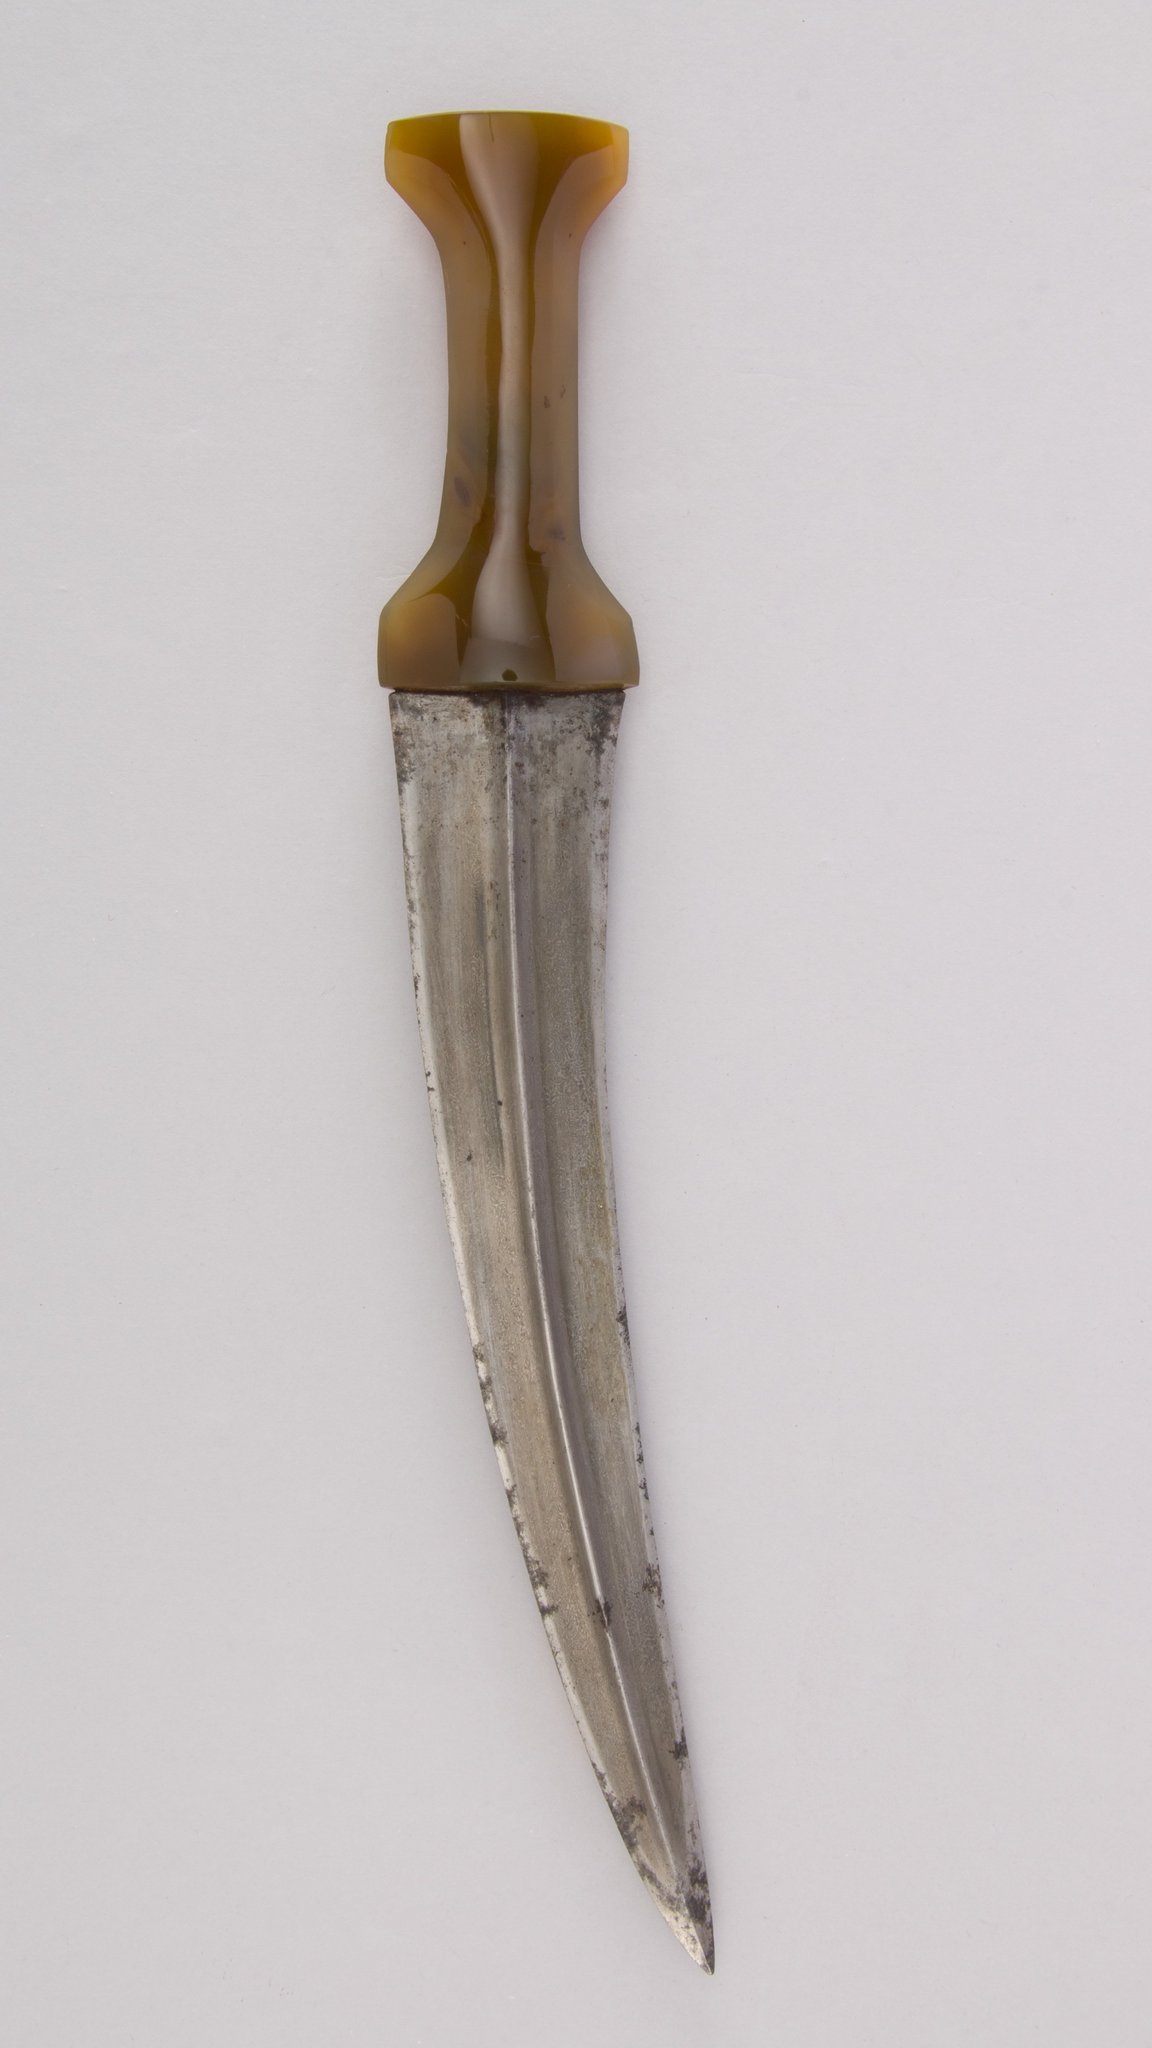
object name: dagger jambiya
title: Dagger (Jambiya)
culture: indian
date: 1801-1900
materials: quartz, steel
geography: india